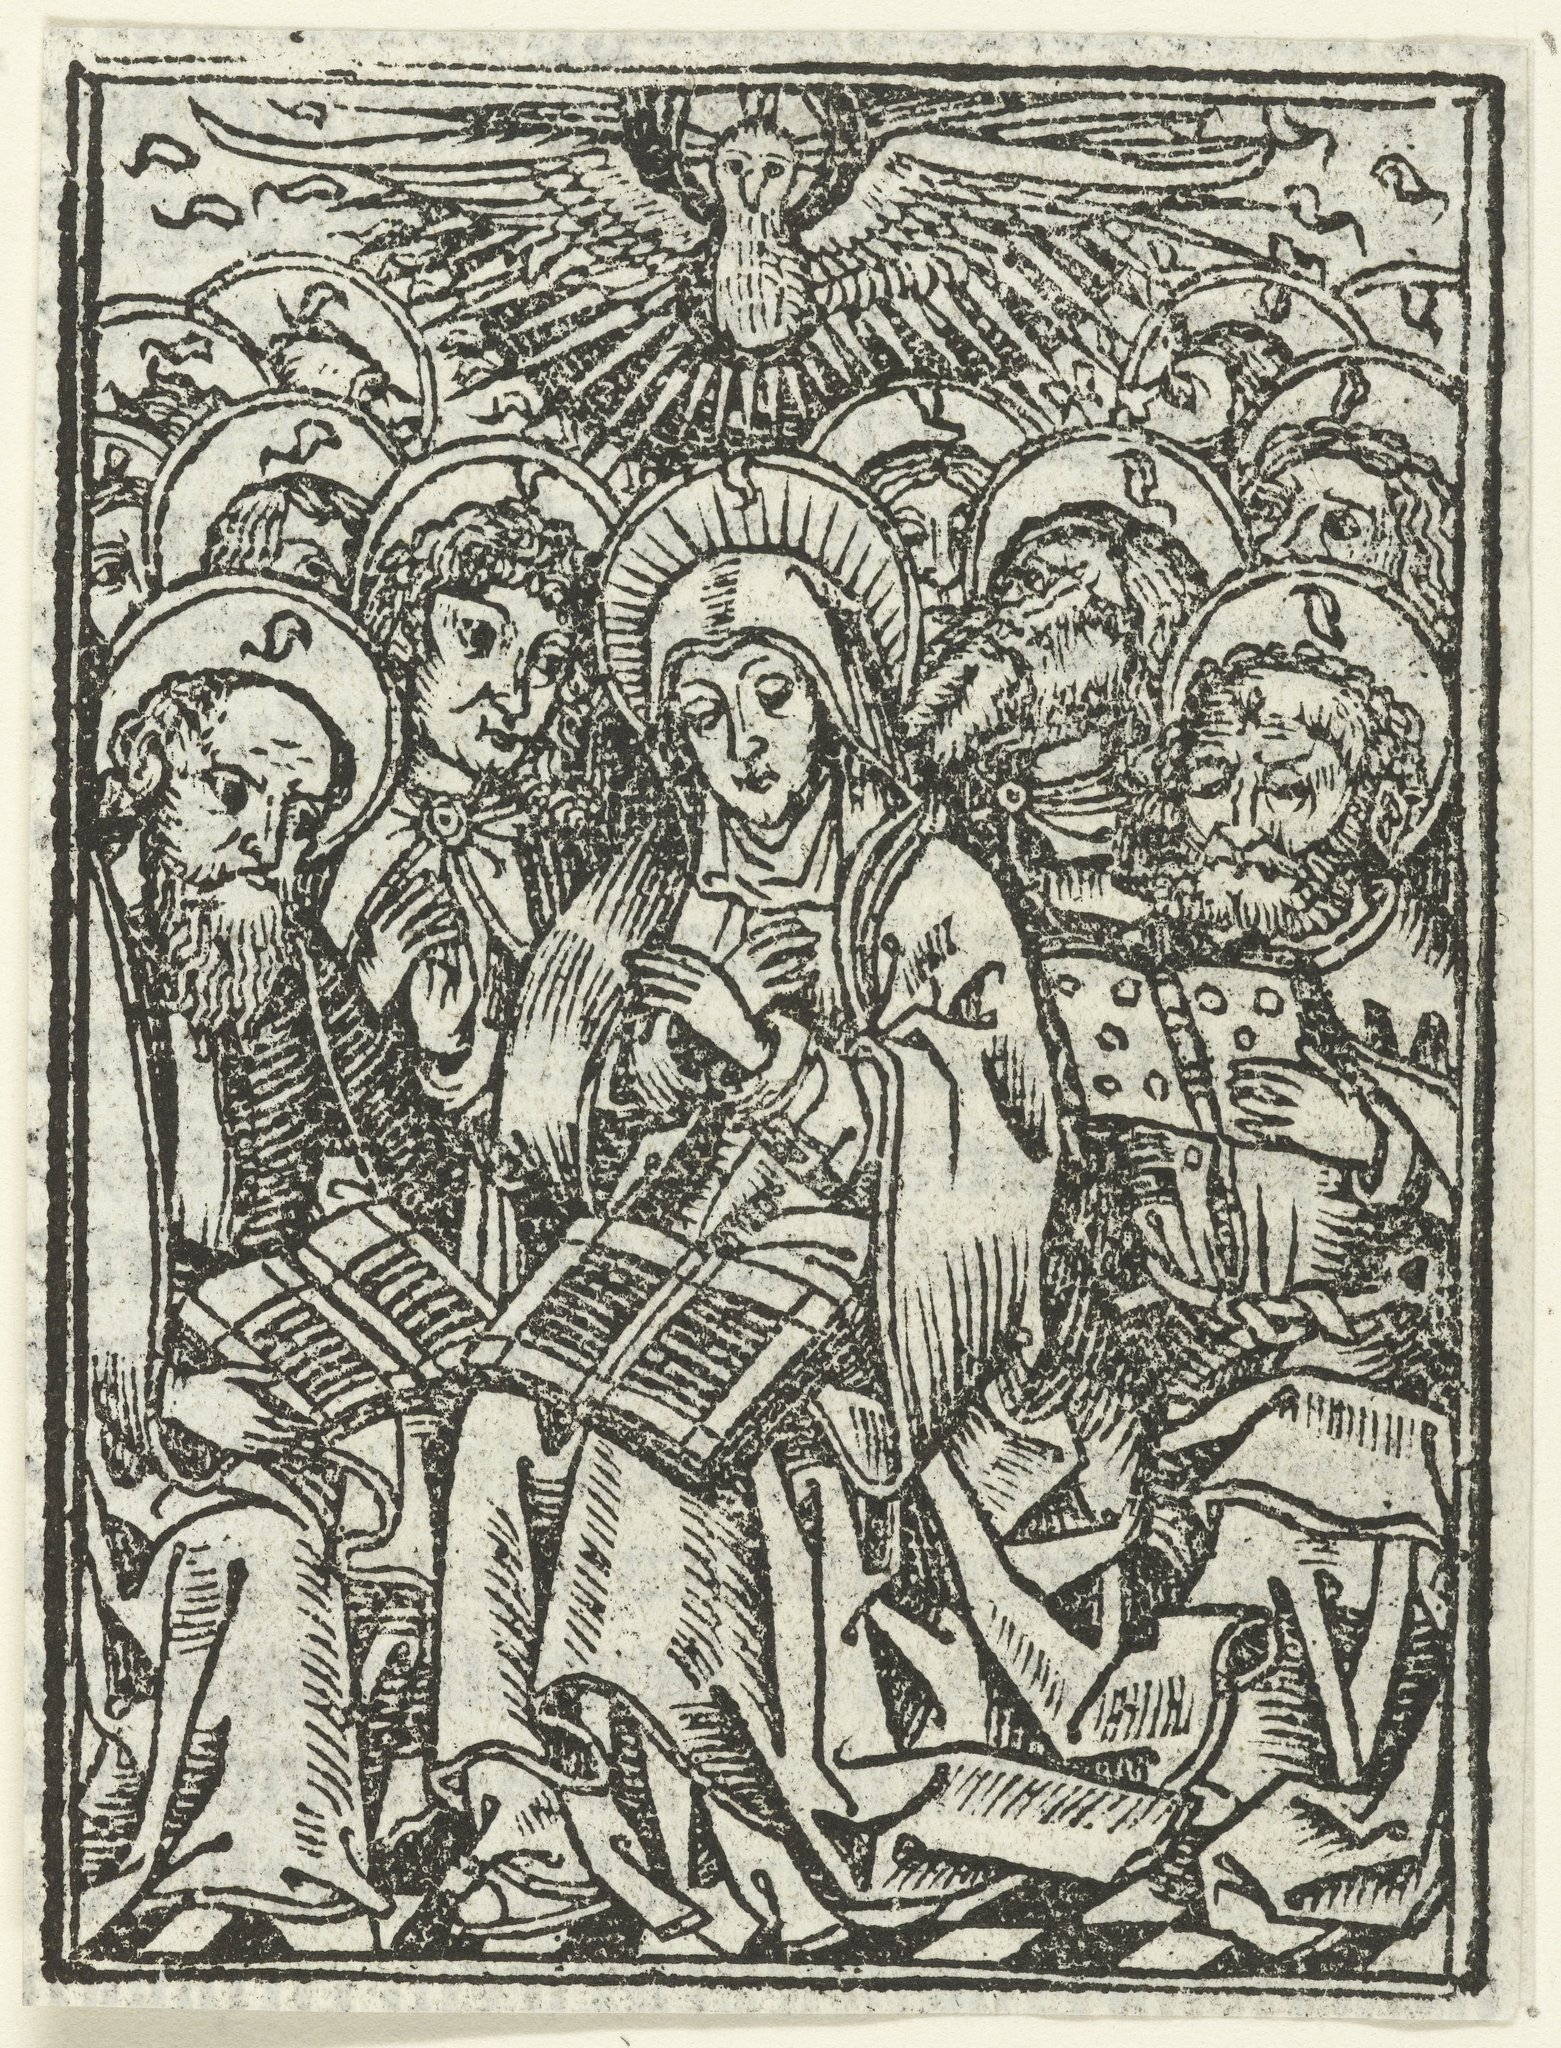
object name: book illustration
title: Uitstorting van de Heilige Geest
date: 1490-1500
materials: paper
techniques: woodcut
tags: pentecost: the holy ghost descends upon (mary and) the apostles, sometimes paul and/or representatives of the nations present (acts 2:1-4)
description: Eén blad van 113 uit Ludolphus de Saxonia, "Dit es dleué ons liefs heeren ihesu christi". Anonieme Nederlandse vertaling. Uitgegeven door Henrick Eckert van Homberch te Antwerpen in 1503. Botke, K. Deze 113 houtsneden, die meestal reeds in vroege Nederlandse boeken gebruikt zijn, worden toegeschreven aan de tweede Meester van Delft, de Meester van de Delbecq-Schreiber-passie en de Meester van de Virgo inter Virgines. In Conway (1884) en in "De gulden passer"(1951) zijn tevens eerdere versies opgenomen. Botke, K.